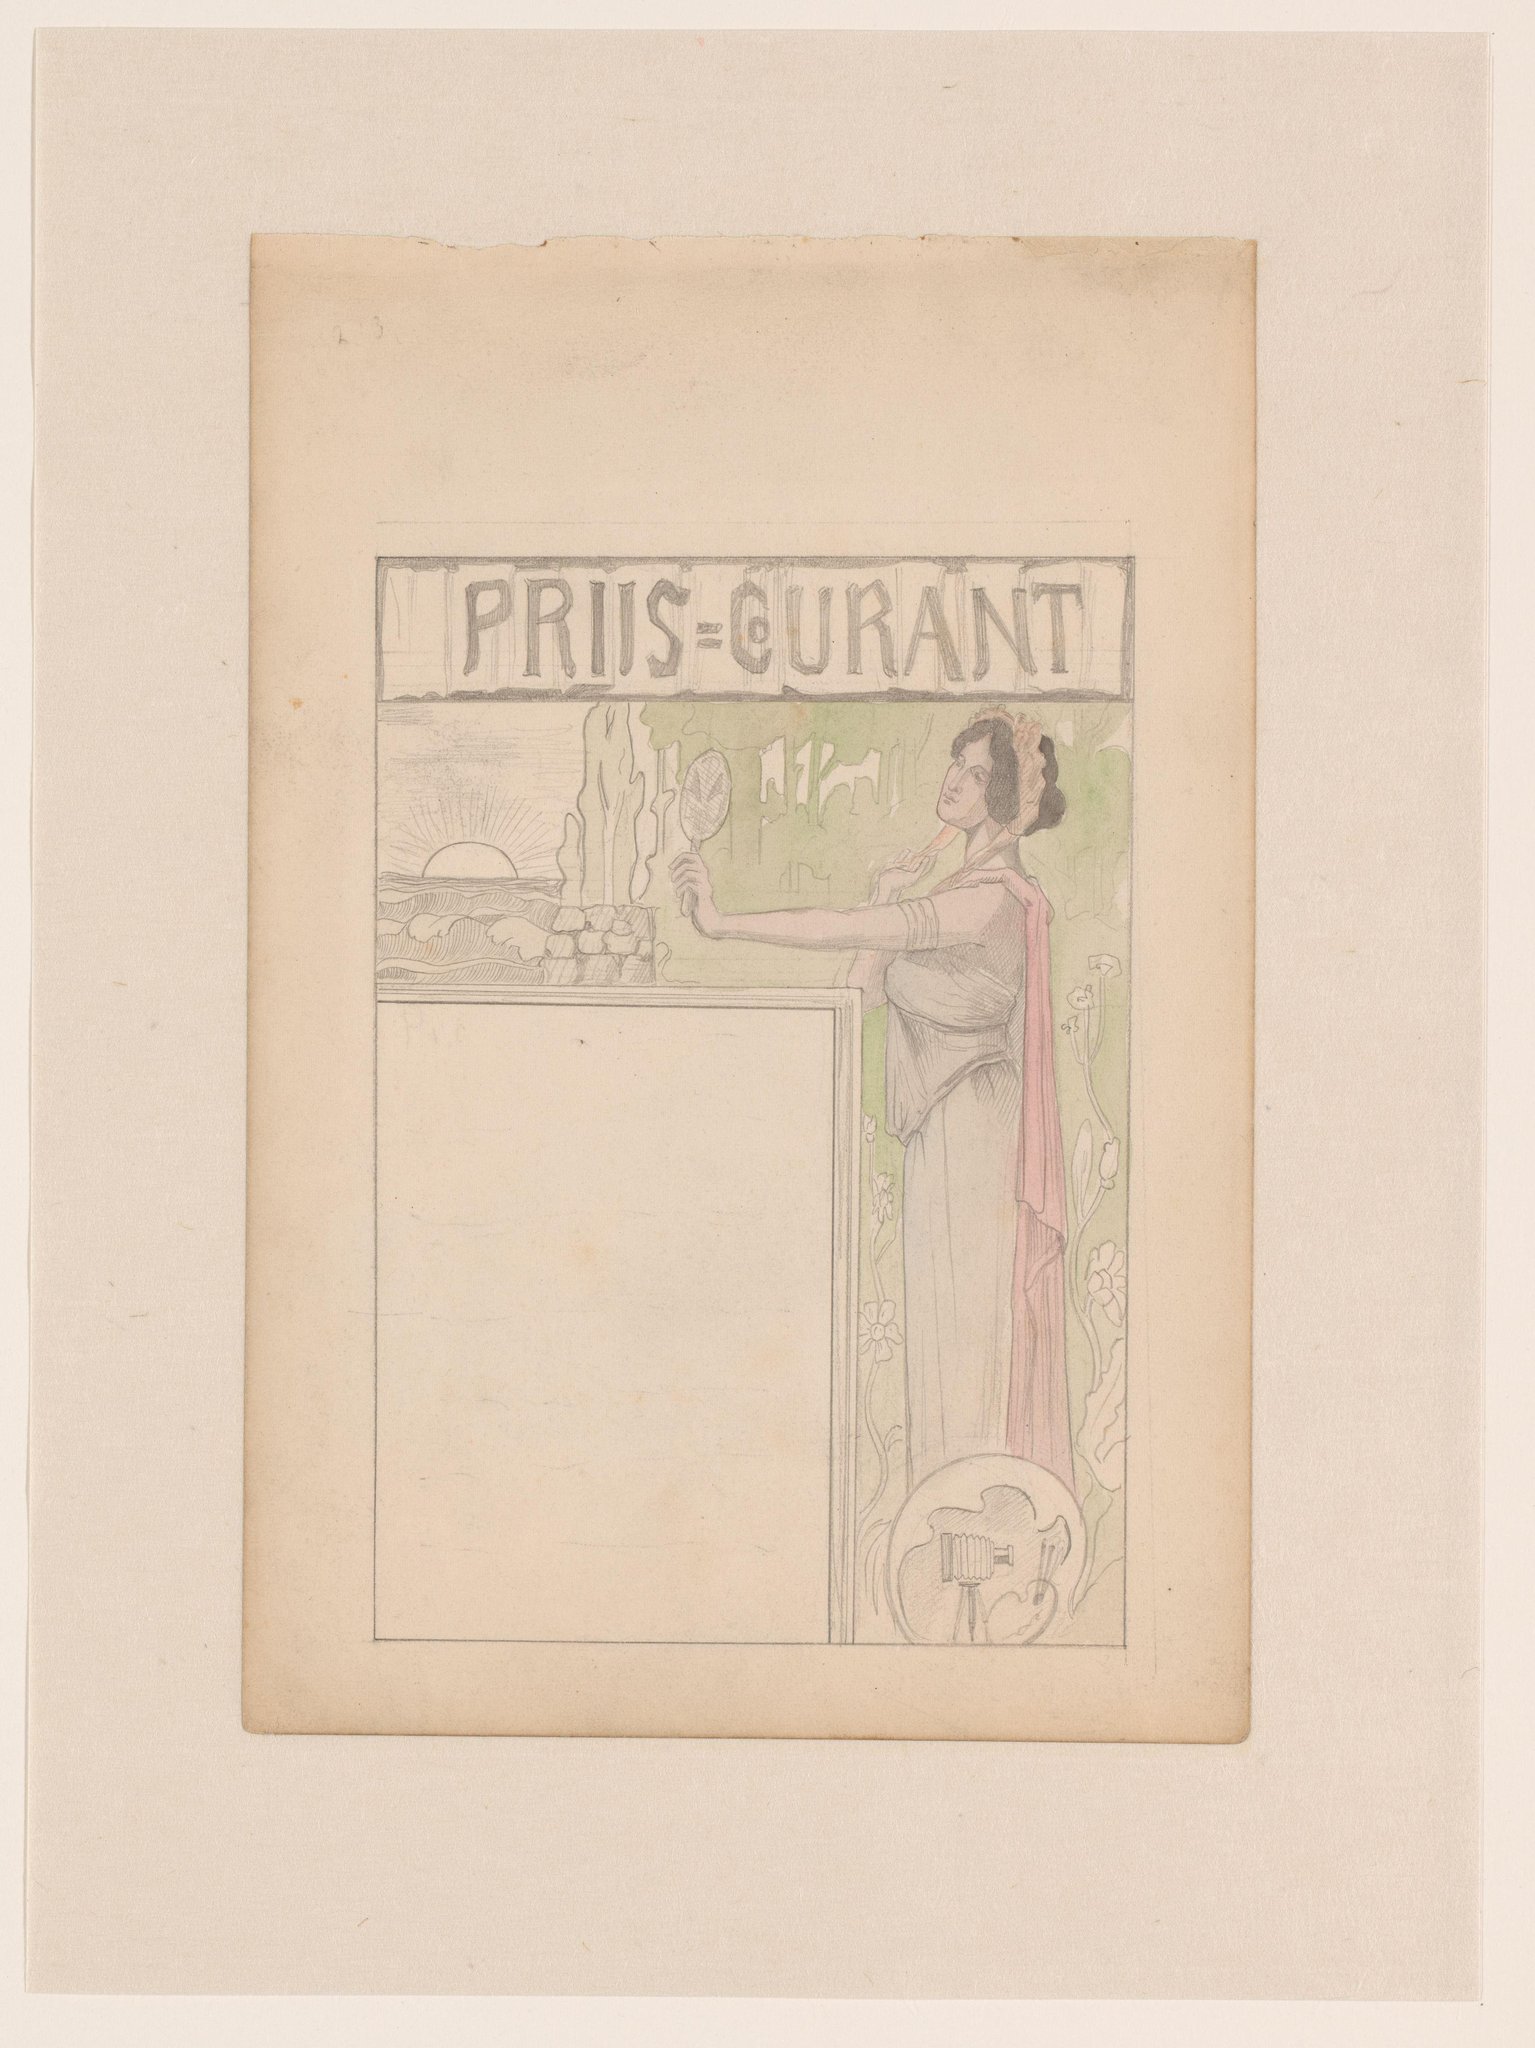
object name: design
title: Ontwerp voor een Prijscourant van een fotografisch atelier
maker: ernst maximilian büttinghausen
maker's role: draughtsman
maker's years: 1883-1929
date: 1893-1906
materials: paper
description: Zeer waarschijnlijk het atelier van zijn vader Max Büttinghausen (overl. 1906)van wie de kunstenaar de opvolger werd. Met opschrift "Prijs-courant" en een vignet met een fototoestel.